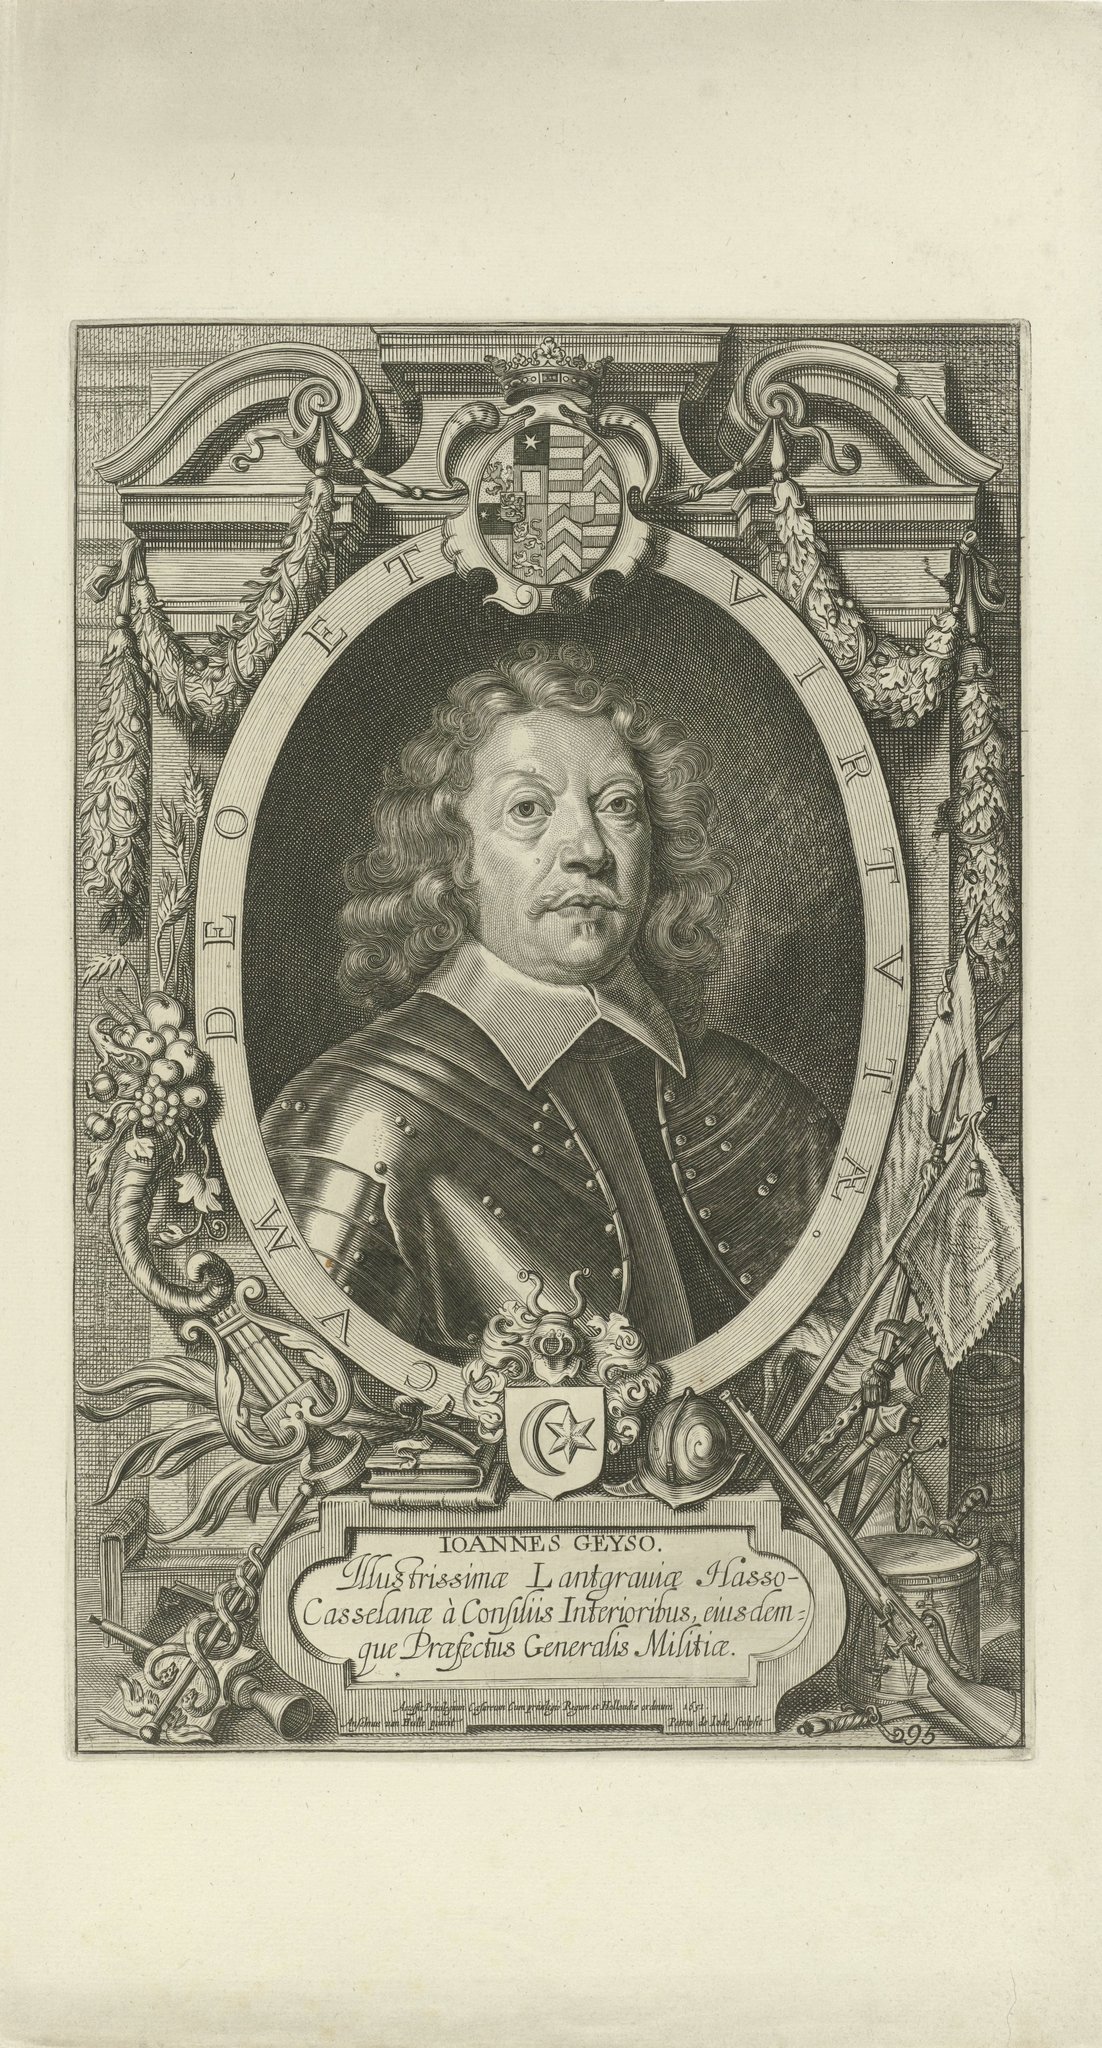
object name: print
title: Hommes illustres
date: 1651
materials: paper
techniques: engraving, etching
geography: antwerp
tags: 'cornucopia', horn of plenty, lyre, cithara, psaltery, armour, weapons, caduceus (staff with two snakes, attribute of mercury)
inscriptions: collector's mark: Lugt 2228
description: Busteportret van Johann Geyso, in harnas. Rechtsonder: 95. Het portret is gevat in een ovale omlijsting met het wapenschild van de geportretteerde en een randschrift in het Latijn. In de cartouche een vierregelig onderschrift in het Latijn. Op de voorgrond diverse wapens, een lier en een caduceus. Prent uit een serie portretten naar schilderijen van Anselmus van Hulle van alle gedelegeerden bij de vredesonderhandelingen te Münster en Osnabrück.